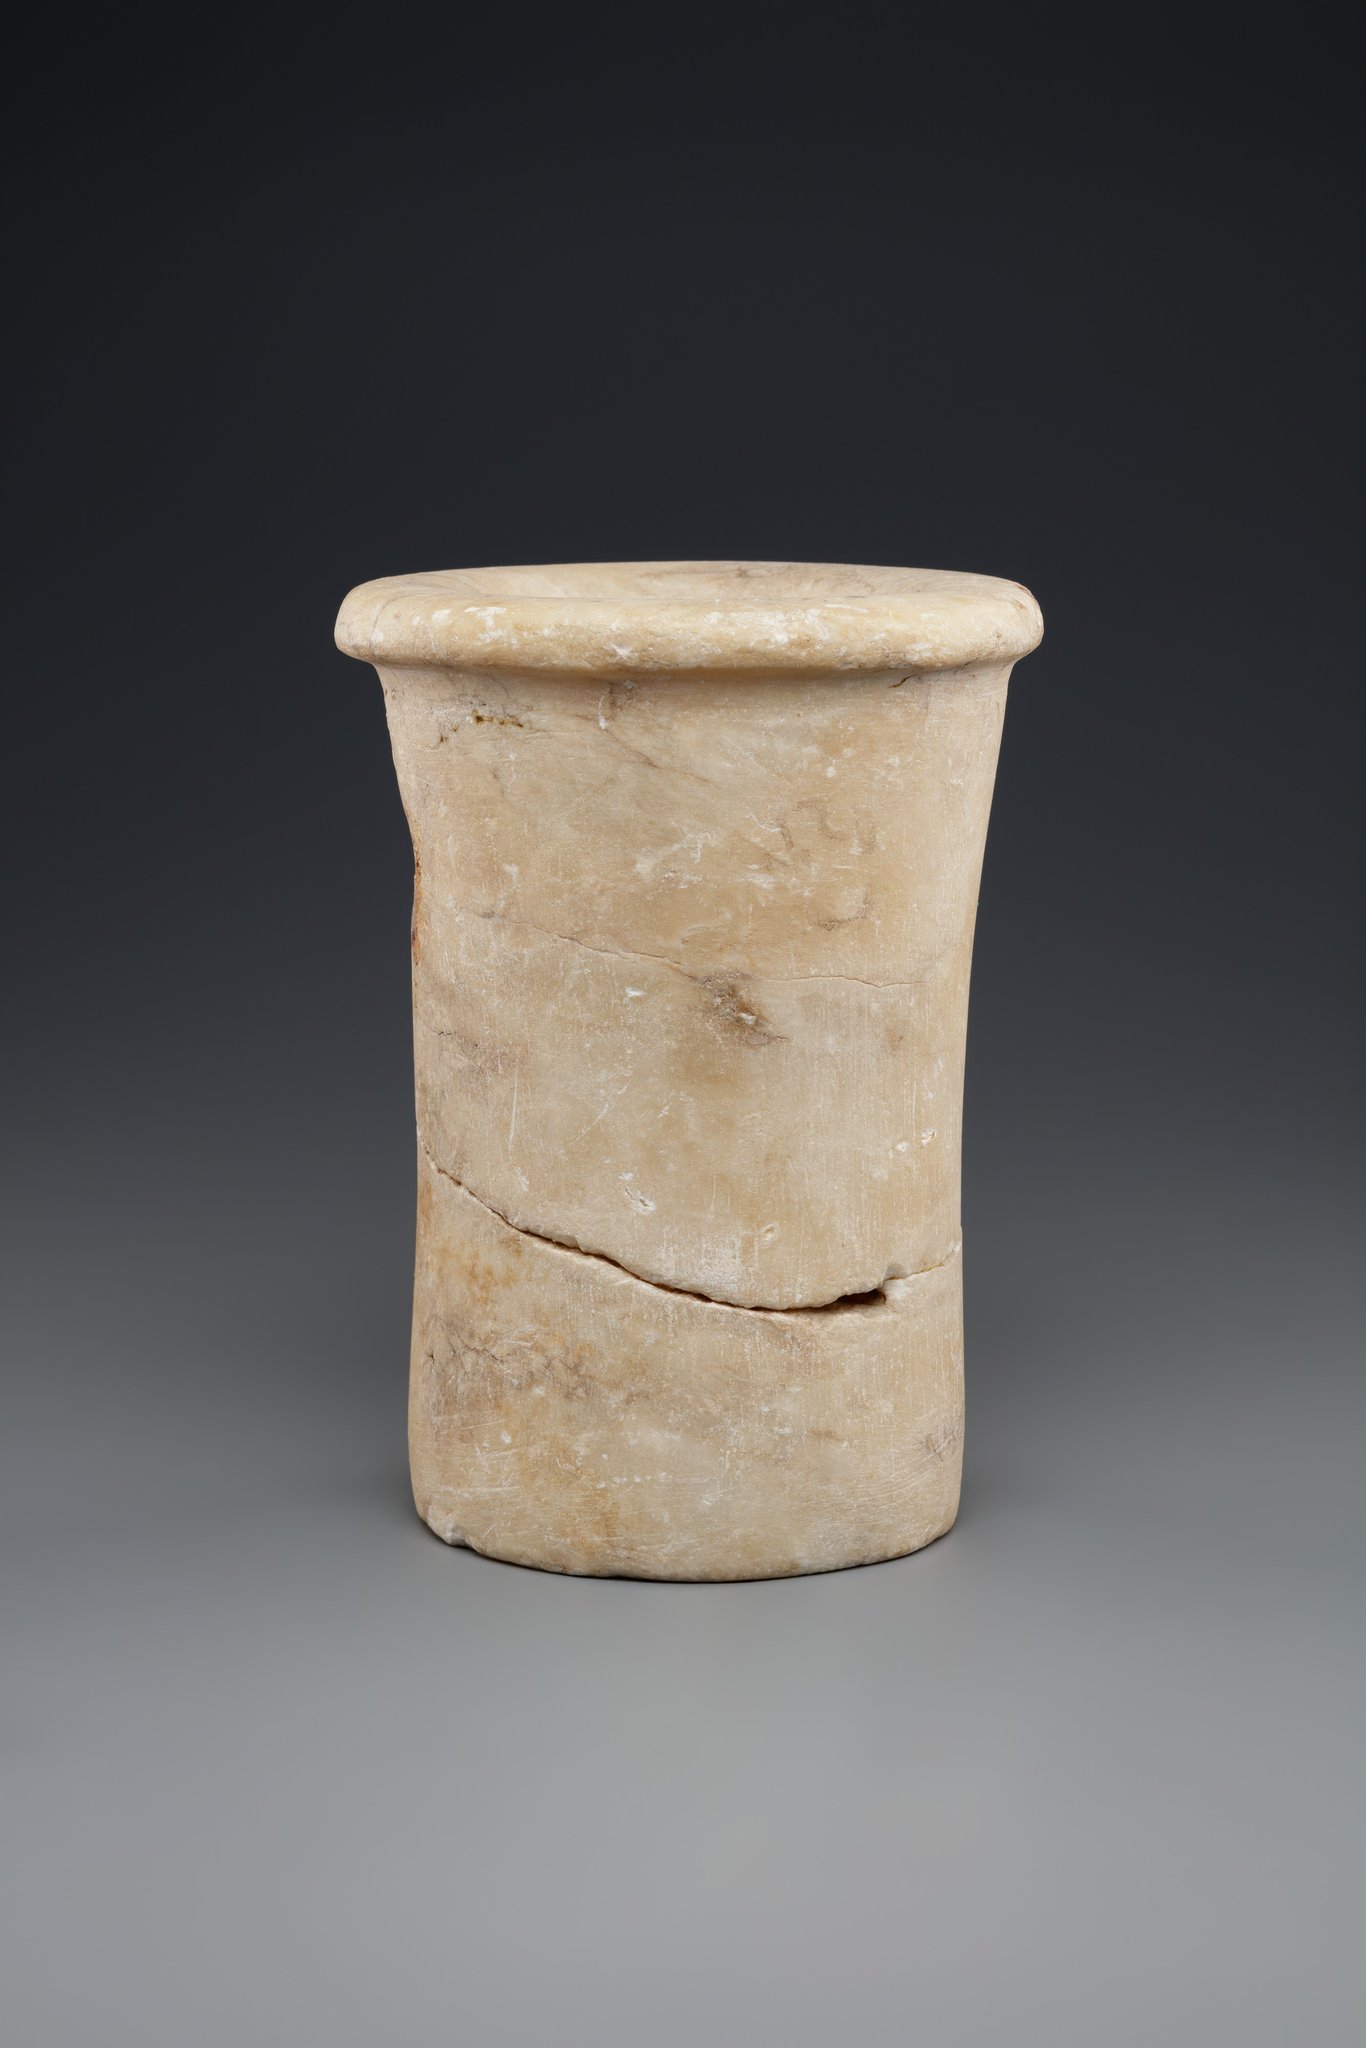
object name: jar, cylindrical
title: Cylinder jar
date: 3100-2649 BCE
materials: stone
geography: egypt